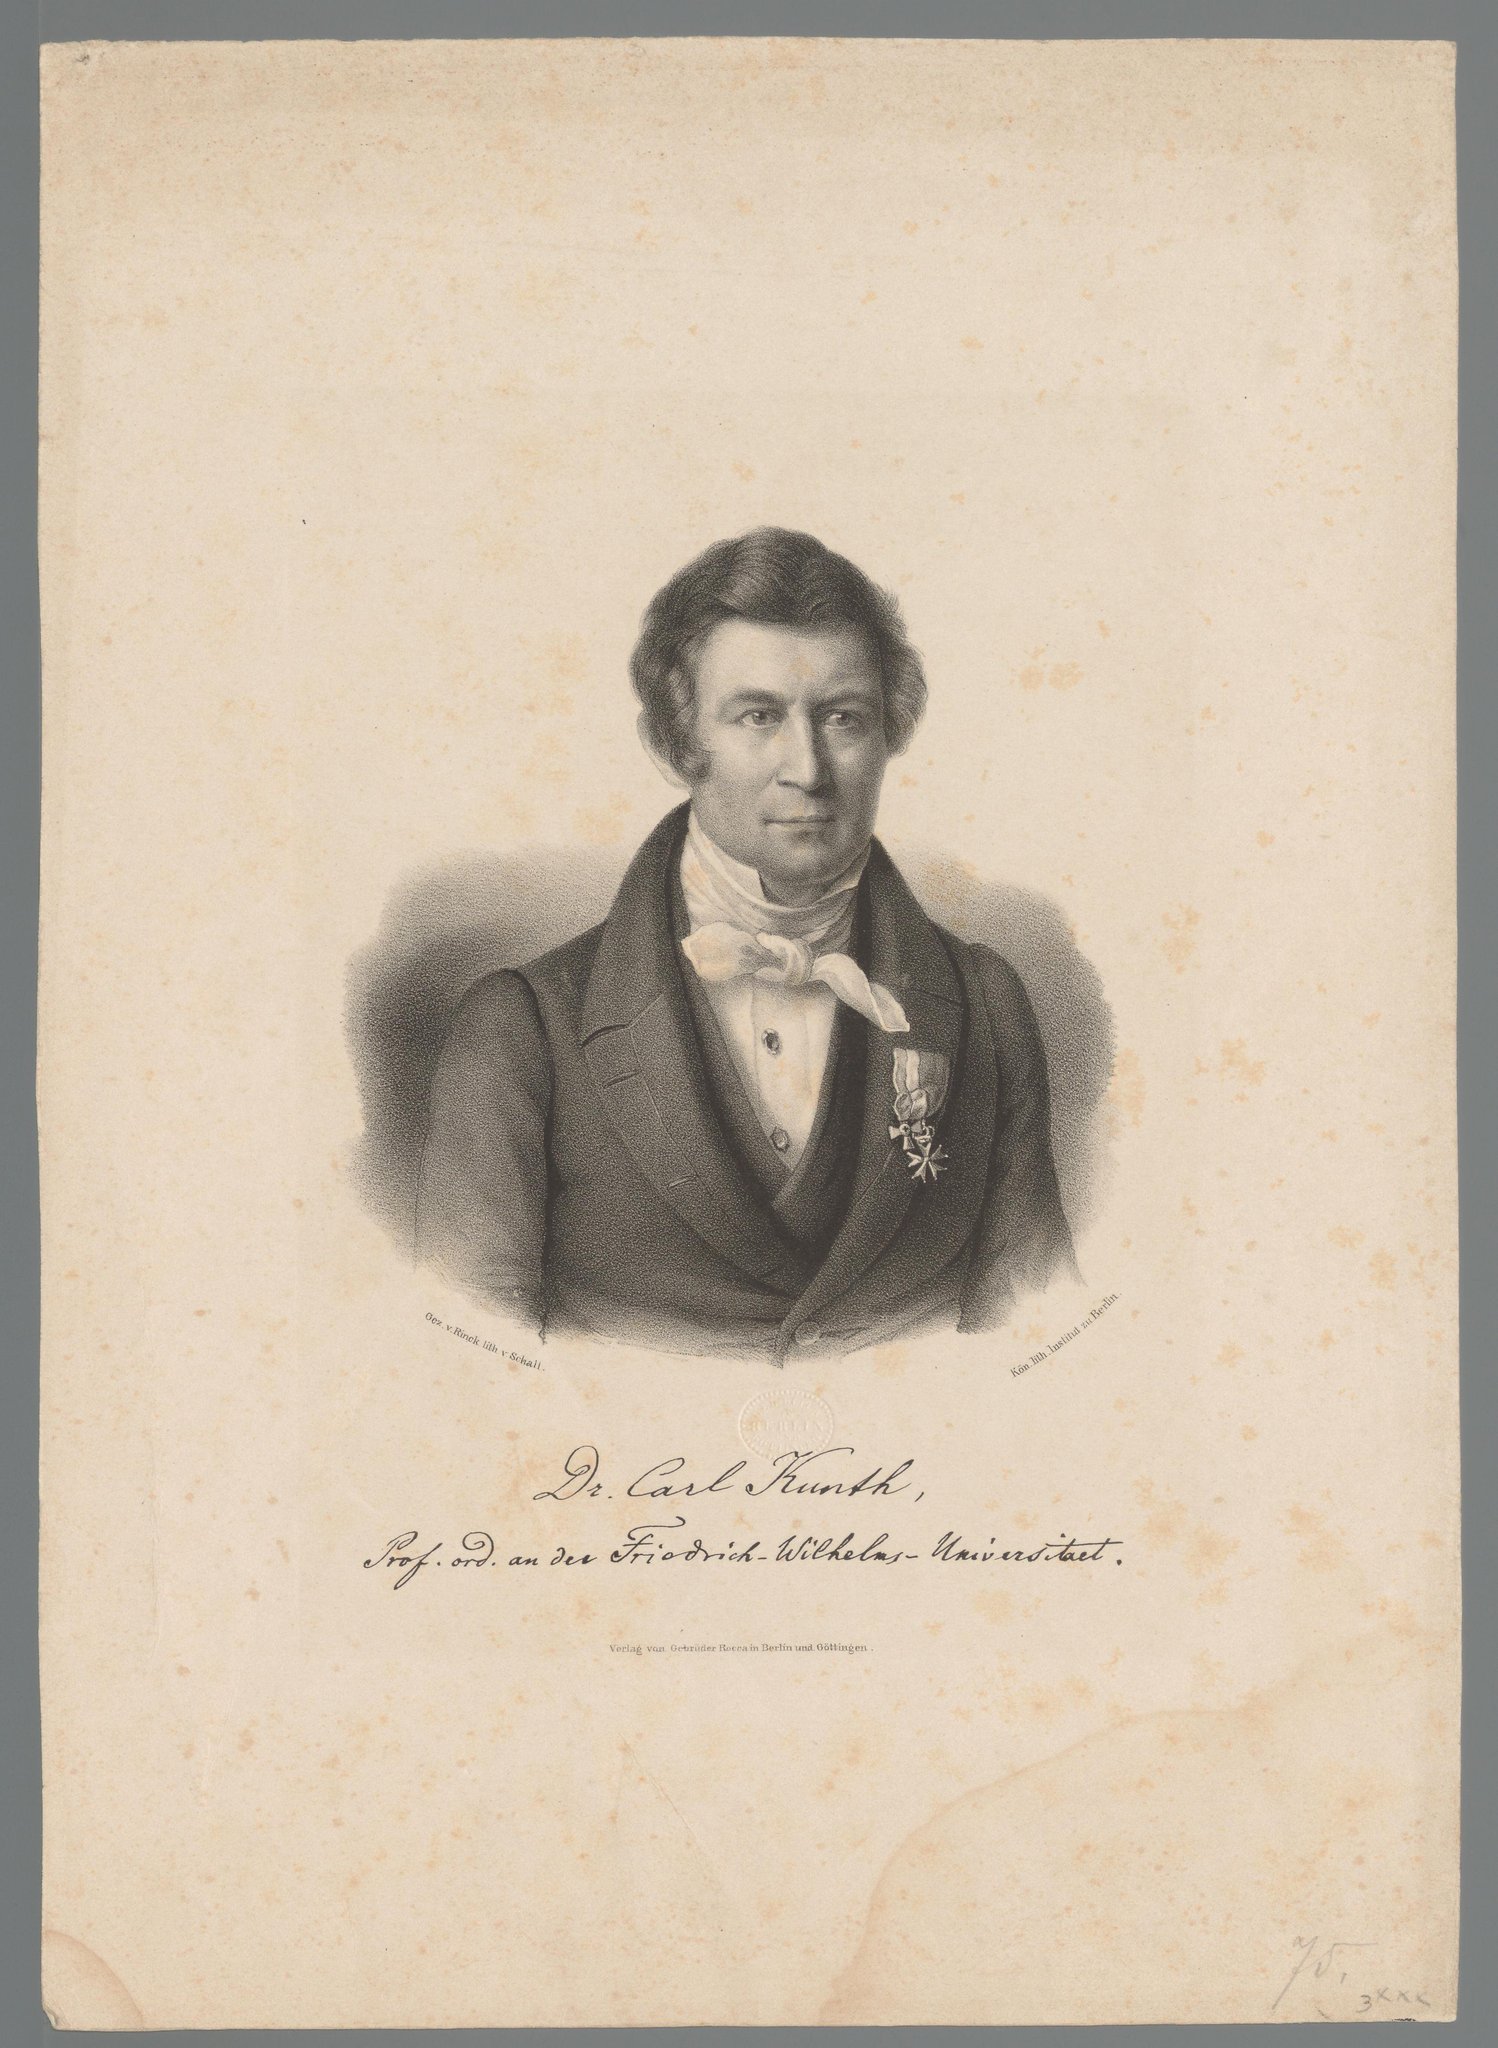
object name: print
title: Portret van Karl Sigismund Kunth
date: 1820-1865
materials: paper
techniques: lithograph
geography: gottingen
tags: adult man, historical persons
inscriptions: check stamp: Lugt 5514, collector's mark: Lugt 2228